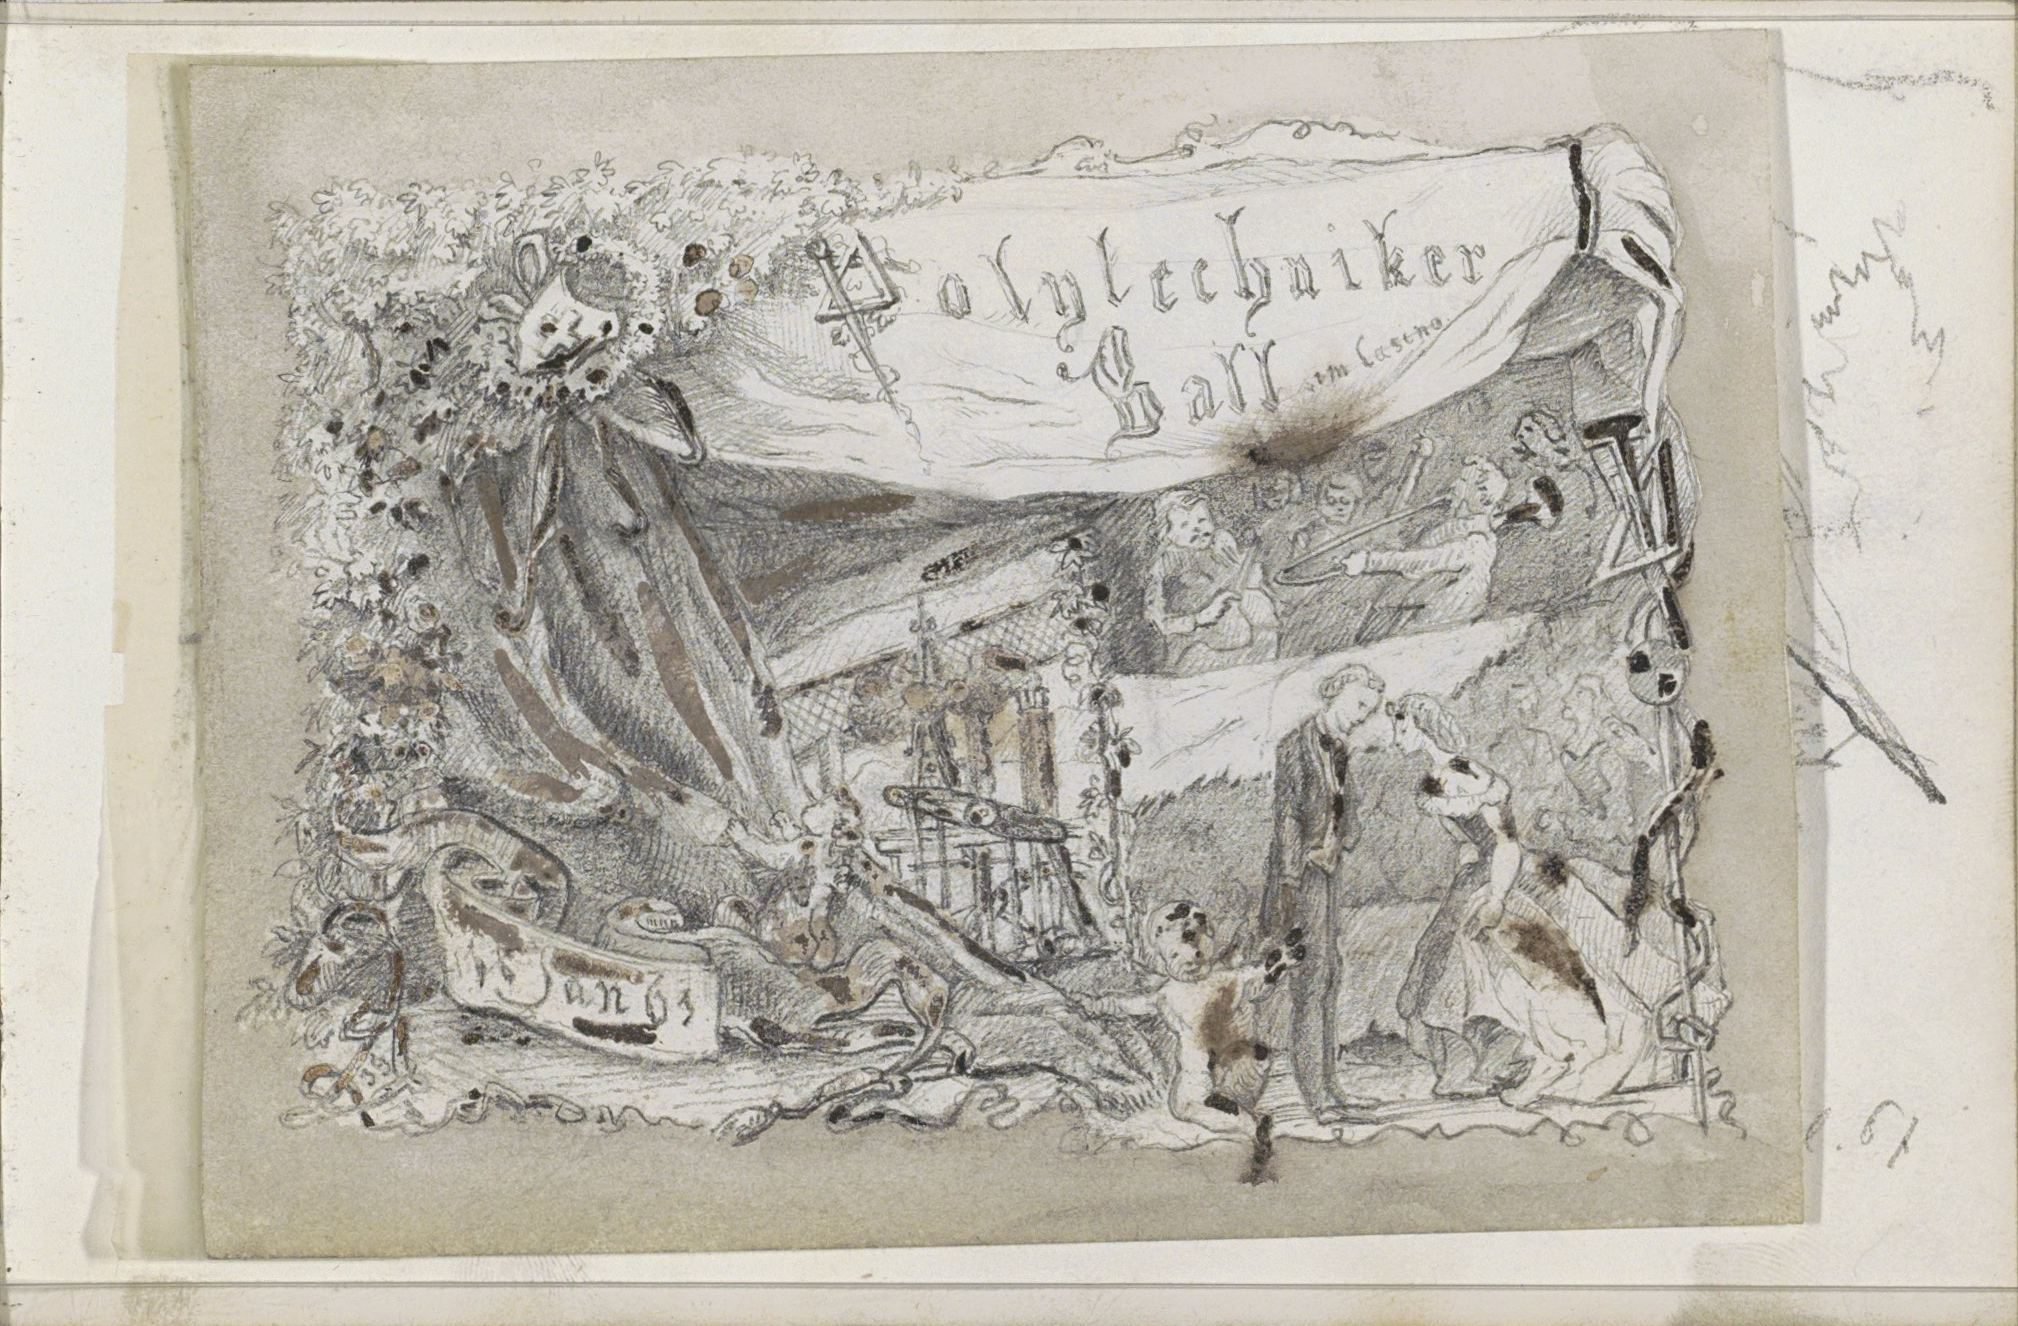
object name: sketchbook leaf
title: Uitnodiging voor een feest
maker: isaac gosschalk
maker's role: draughtsman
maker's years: 1838-1907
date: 1861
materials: paper, pencil, watercolor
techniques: brush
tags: small group of musicians, chamber orchestra, jazz band, trees, couple of lovers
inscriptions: annotation: ‘Polytechniker/ Barr im Casi?no/ 16 Jan 61’, annotation: ‘Einladung/ für/ fräulein/ geteekend in Zürich 61/ slecht uitgevoerd in Druck’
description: De uitnodiging toont een paar in feestelijke kleding bij een boom. Op de achtergrond is een gezelschap dat muziek speelt te zien. Ingeplakte tekening tussen blad 13 verso en 14 recto uit een schetsboek met 29 bladen.